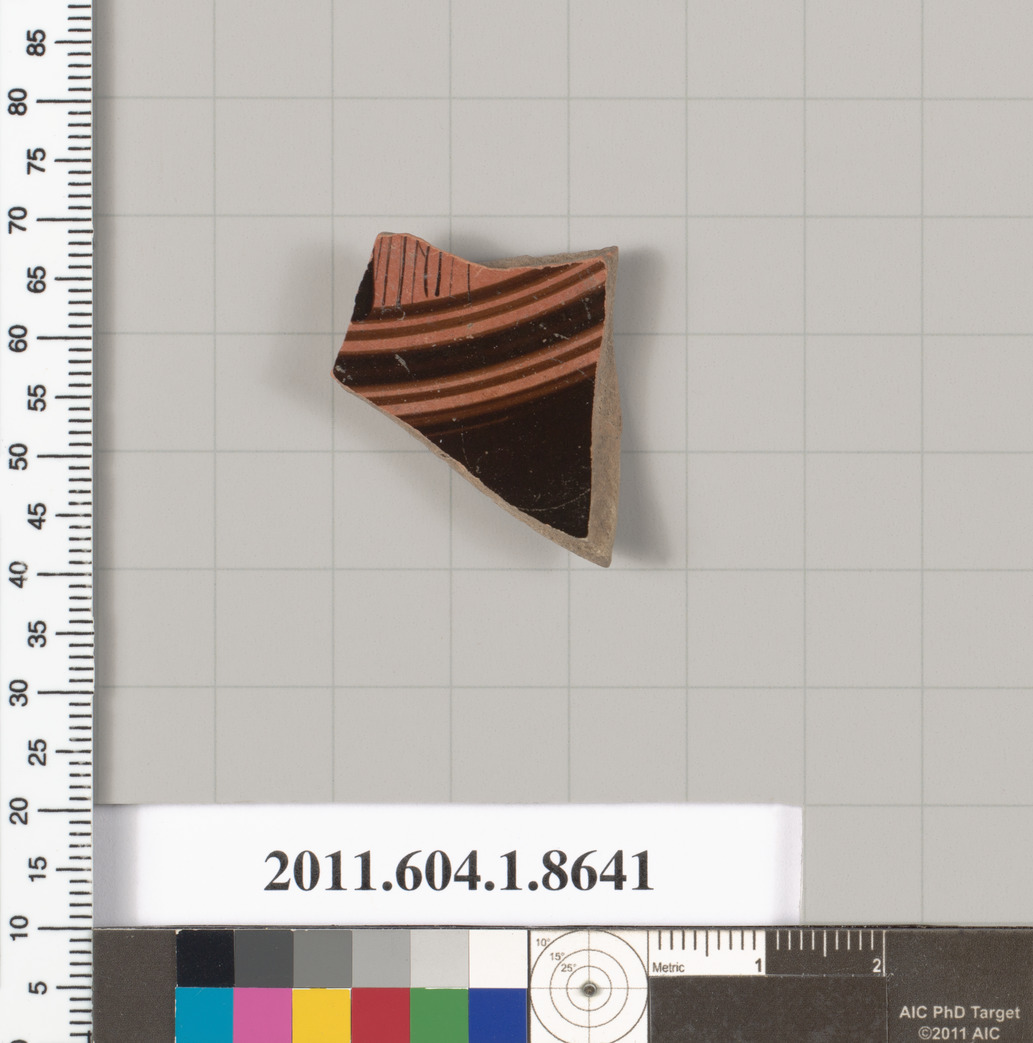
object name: kylix fragment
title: Terracotta fragment of a stemless kylix (drinking cup)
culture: greek, attic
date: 467-435 BCE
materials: terracotta